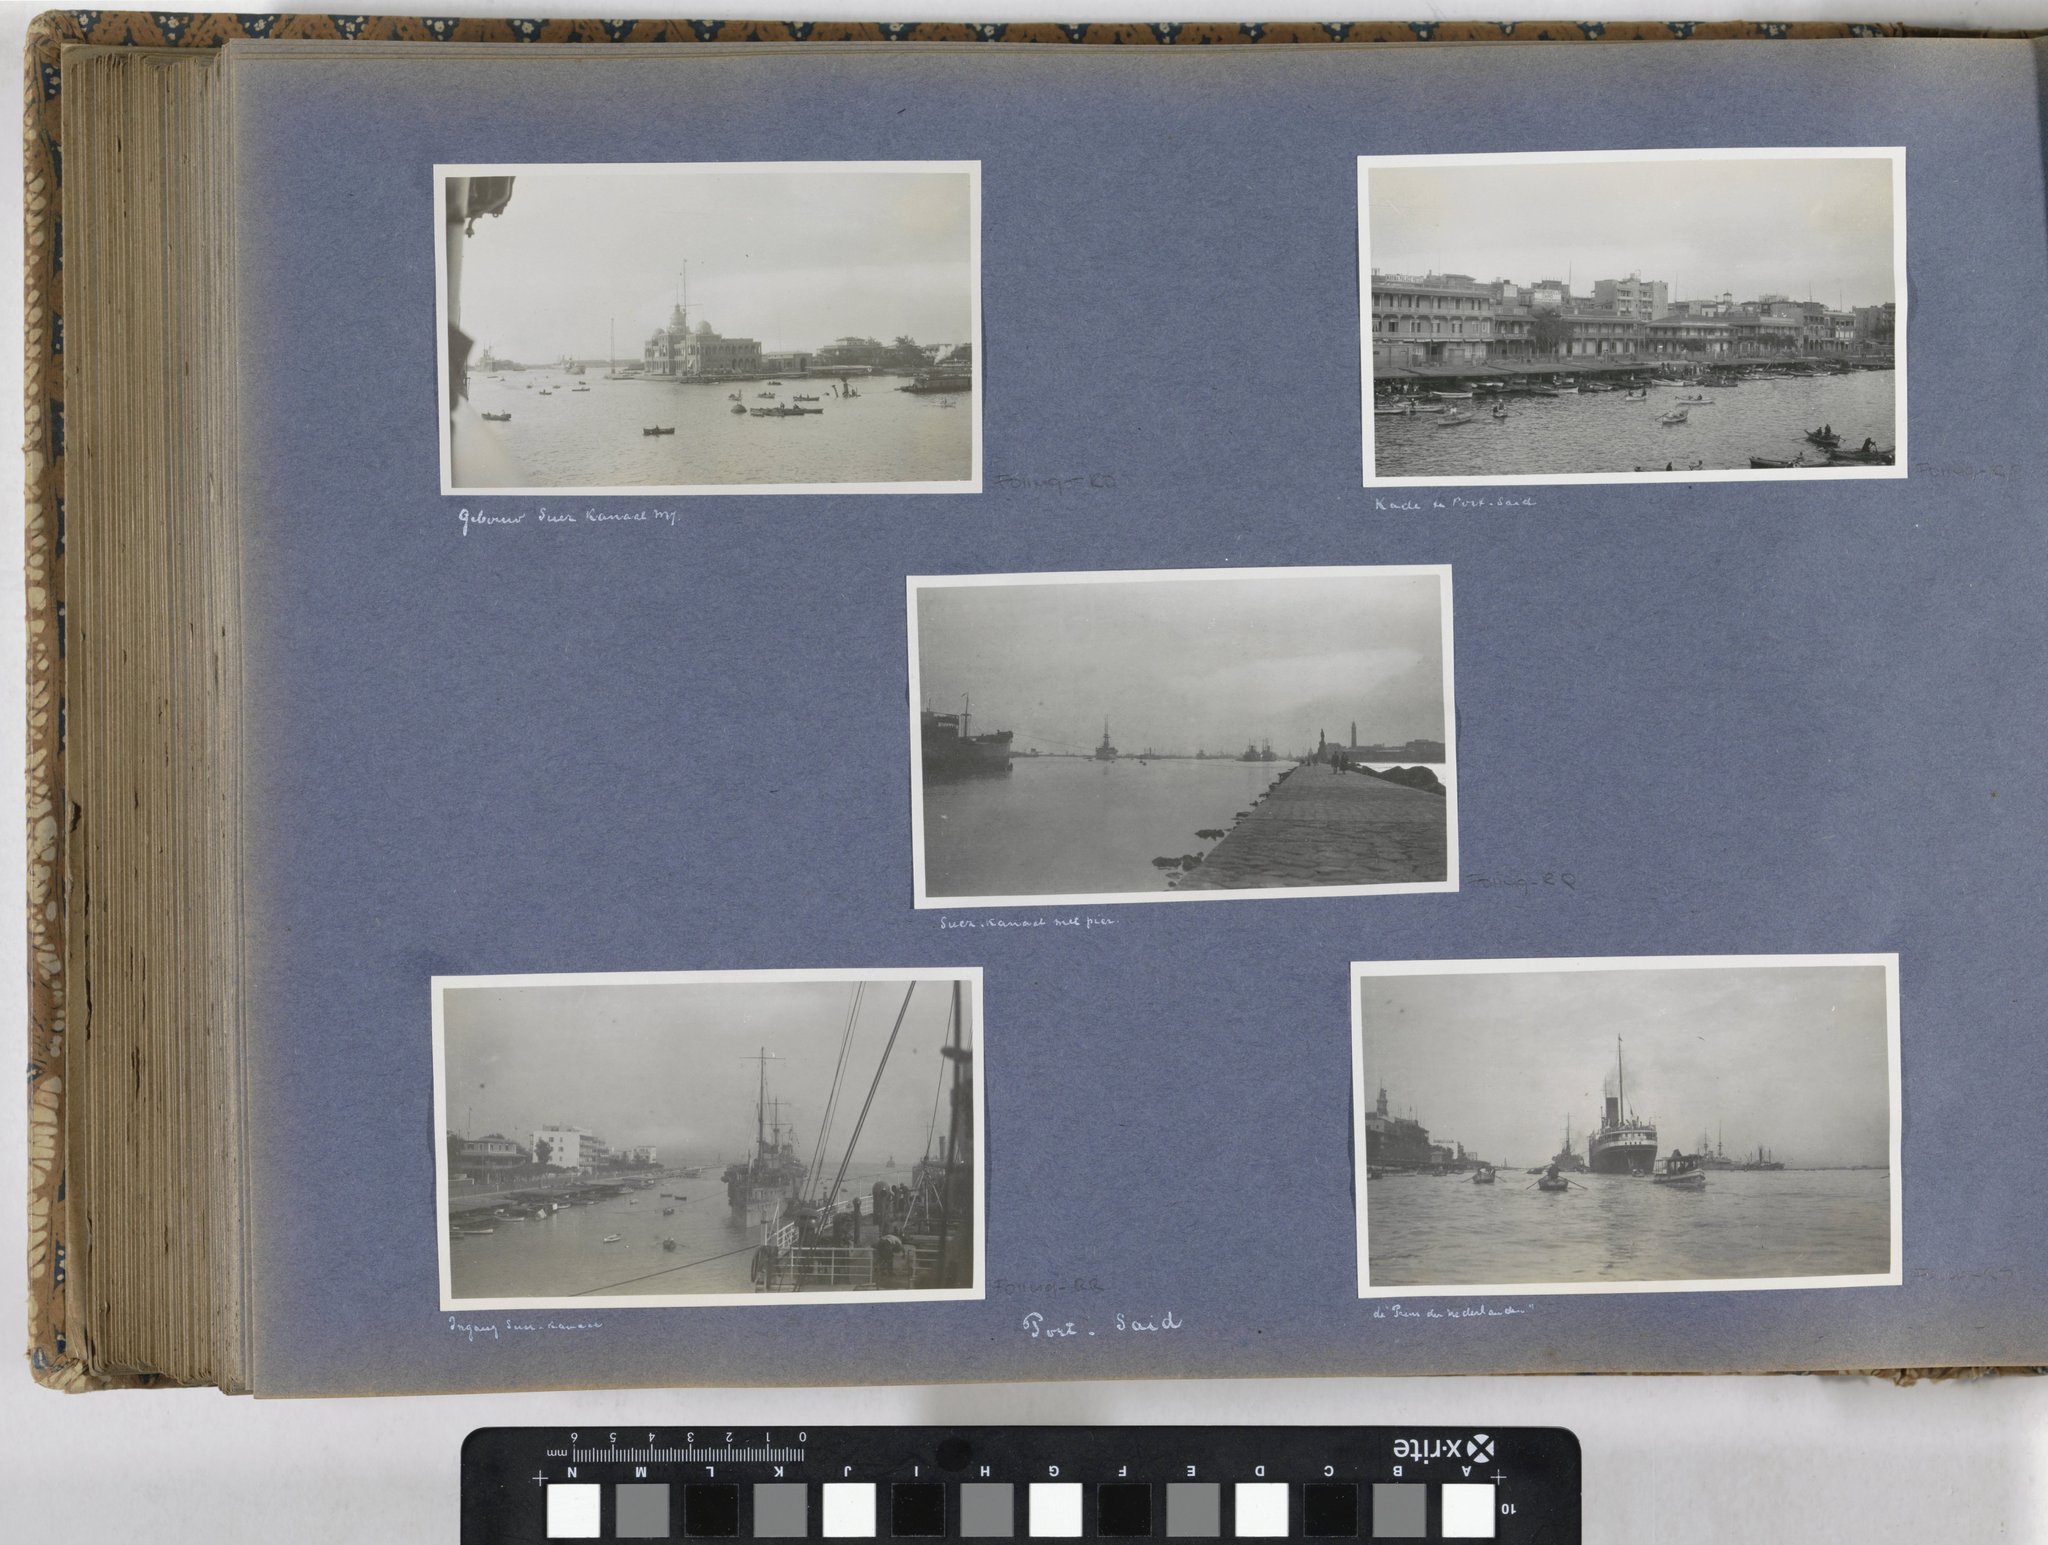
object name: album leaf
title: Exterieur van het kantoor van de Suezkanaal Maatschappij in Port Said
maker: Anonymous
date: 1900-1920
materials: paper, photographic support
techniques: gelatin silver print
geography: port said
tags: harbour (+ view ~ vehicle, ship, etc.), exterior ~ representation of a building, office (~ administration)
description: Onderdeel van reisalbum met foto's van bedrijvigheid en bezienswaardigheden op Sumatra en Java en van de reis naar en van Nederlands-Indië.